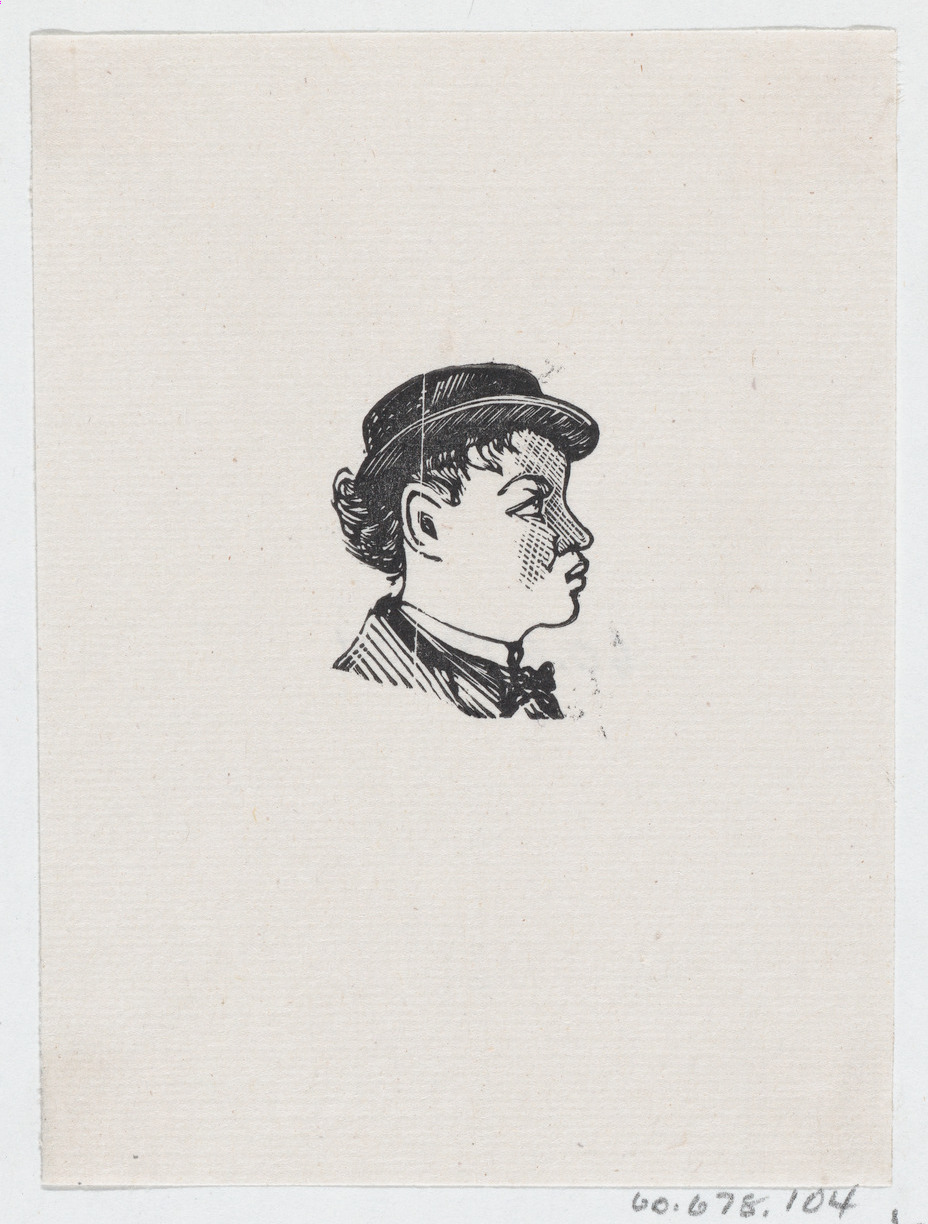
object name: print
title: A profile of a boy with a hat looking to the right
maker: josé guadalupe posada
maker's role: artist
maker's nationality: mexican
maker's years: 1852-1913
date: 1880-1910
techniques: lithography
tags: boys,profiles